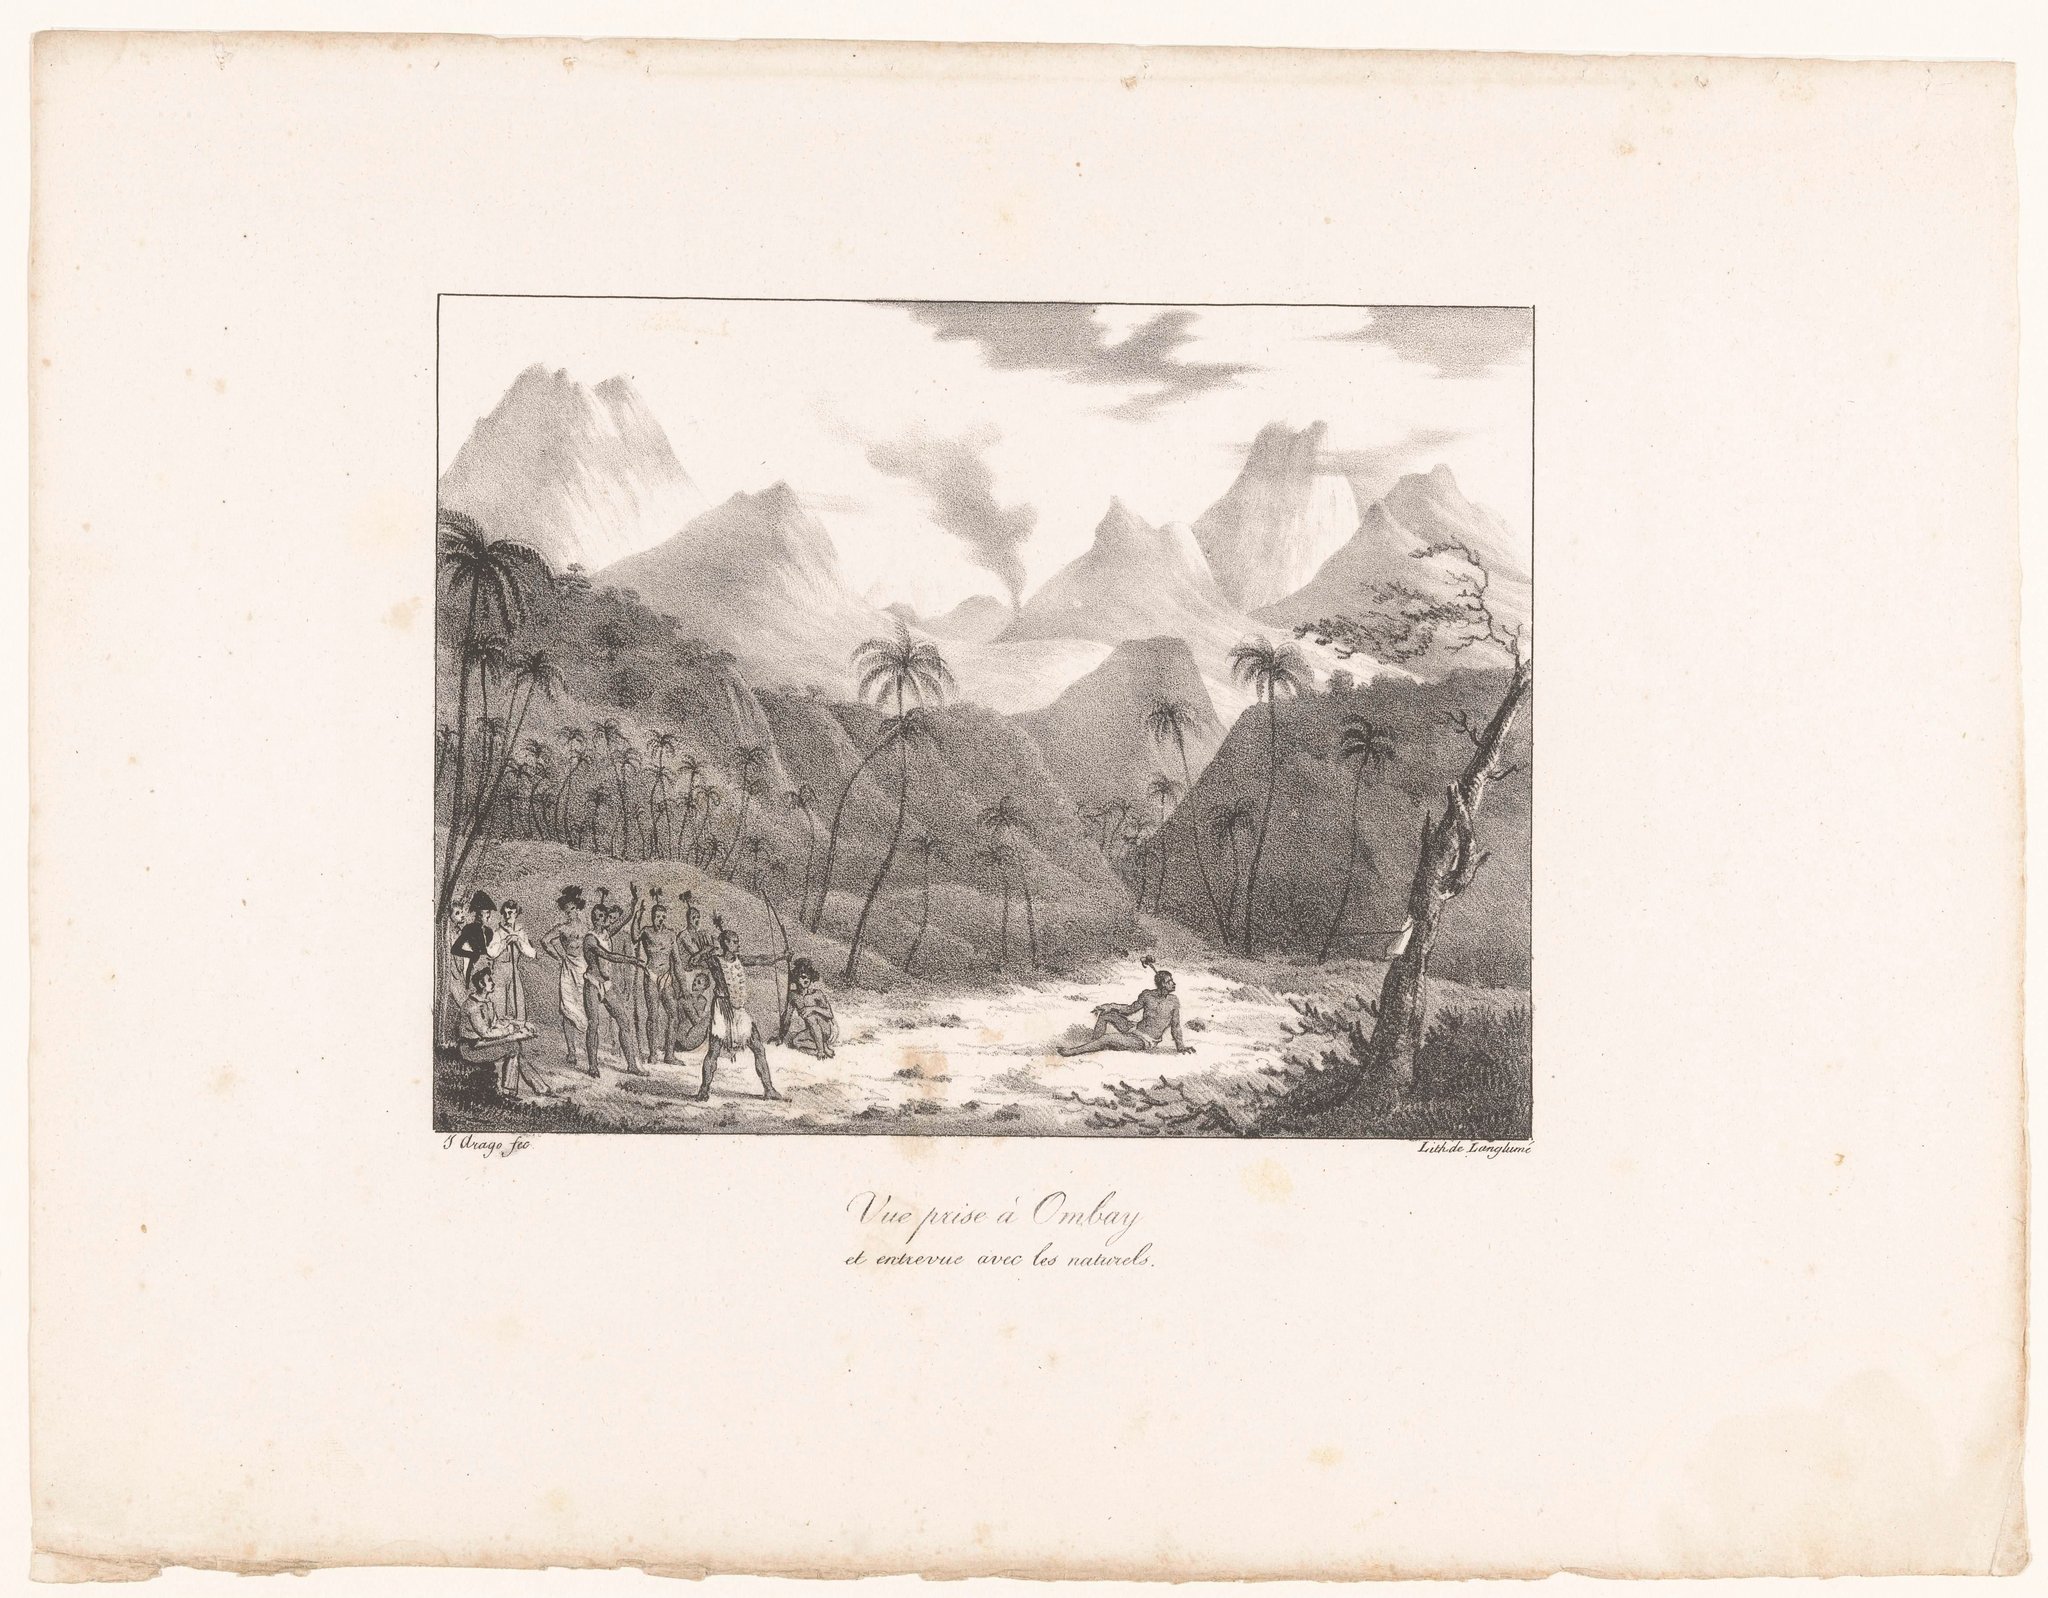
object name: print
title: Ontmoeting met de inwoners van Ombay in Indonesië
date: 1822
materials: paper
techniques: lithograph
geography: paris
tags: relations between races, meeting, mountains (in tropical and sub-tropical regions)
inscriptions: collector's mark: Lugt 2228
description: Prent mogelijk uit een album dat is uitgegeven bij: Arago, J.E.V. Promenade autour de monde pendant les années 1817, 1818, 1819 et 1820, sur les corvettes du roi l'Uranie et la Physicienne, commandées par M. Freycinet. 2 dln. Parijs: Leblanc, 1822.